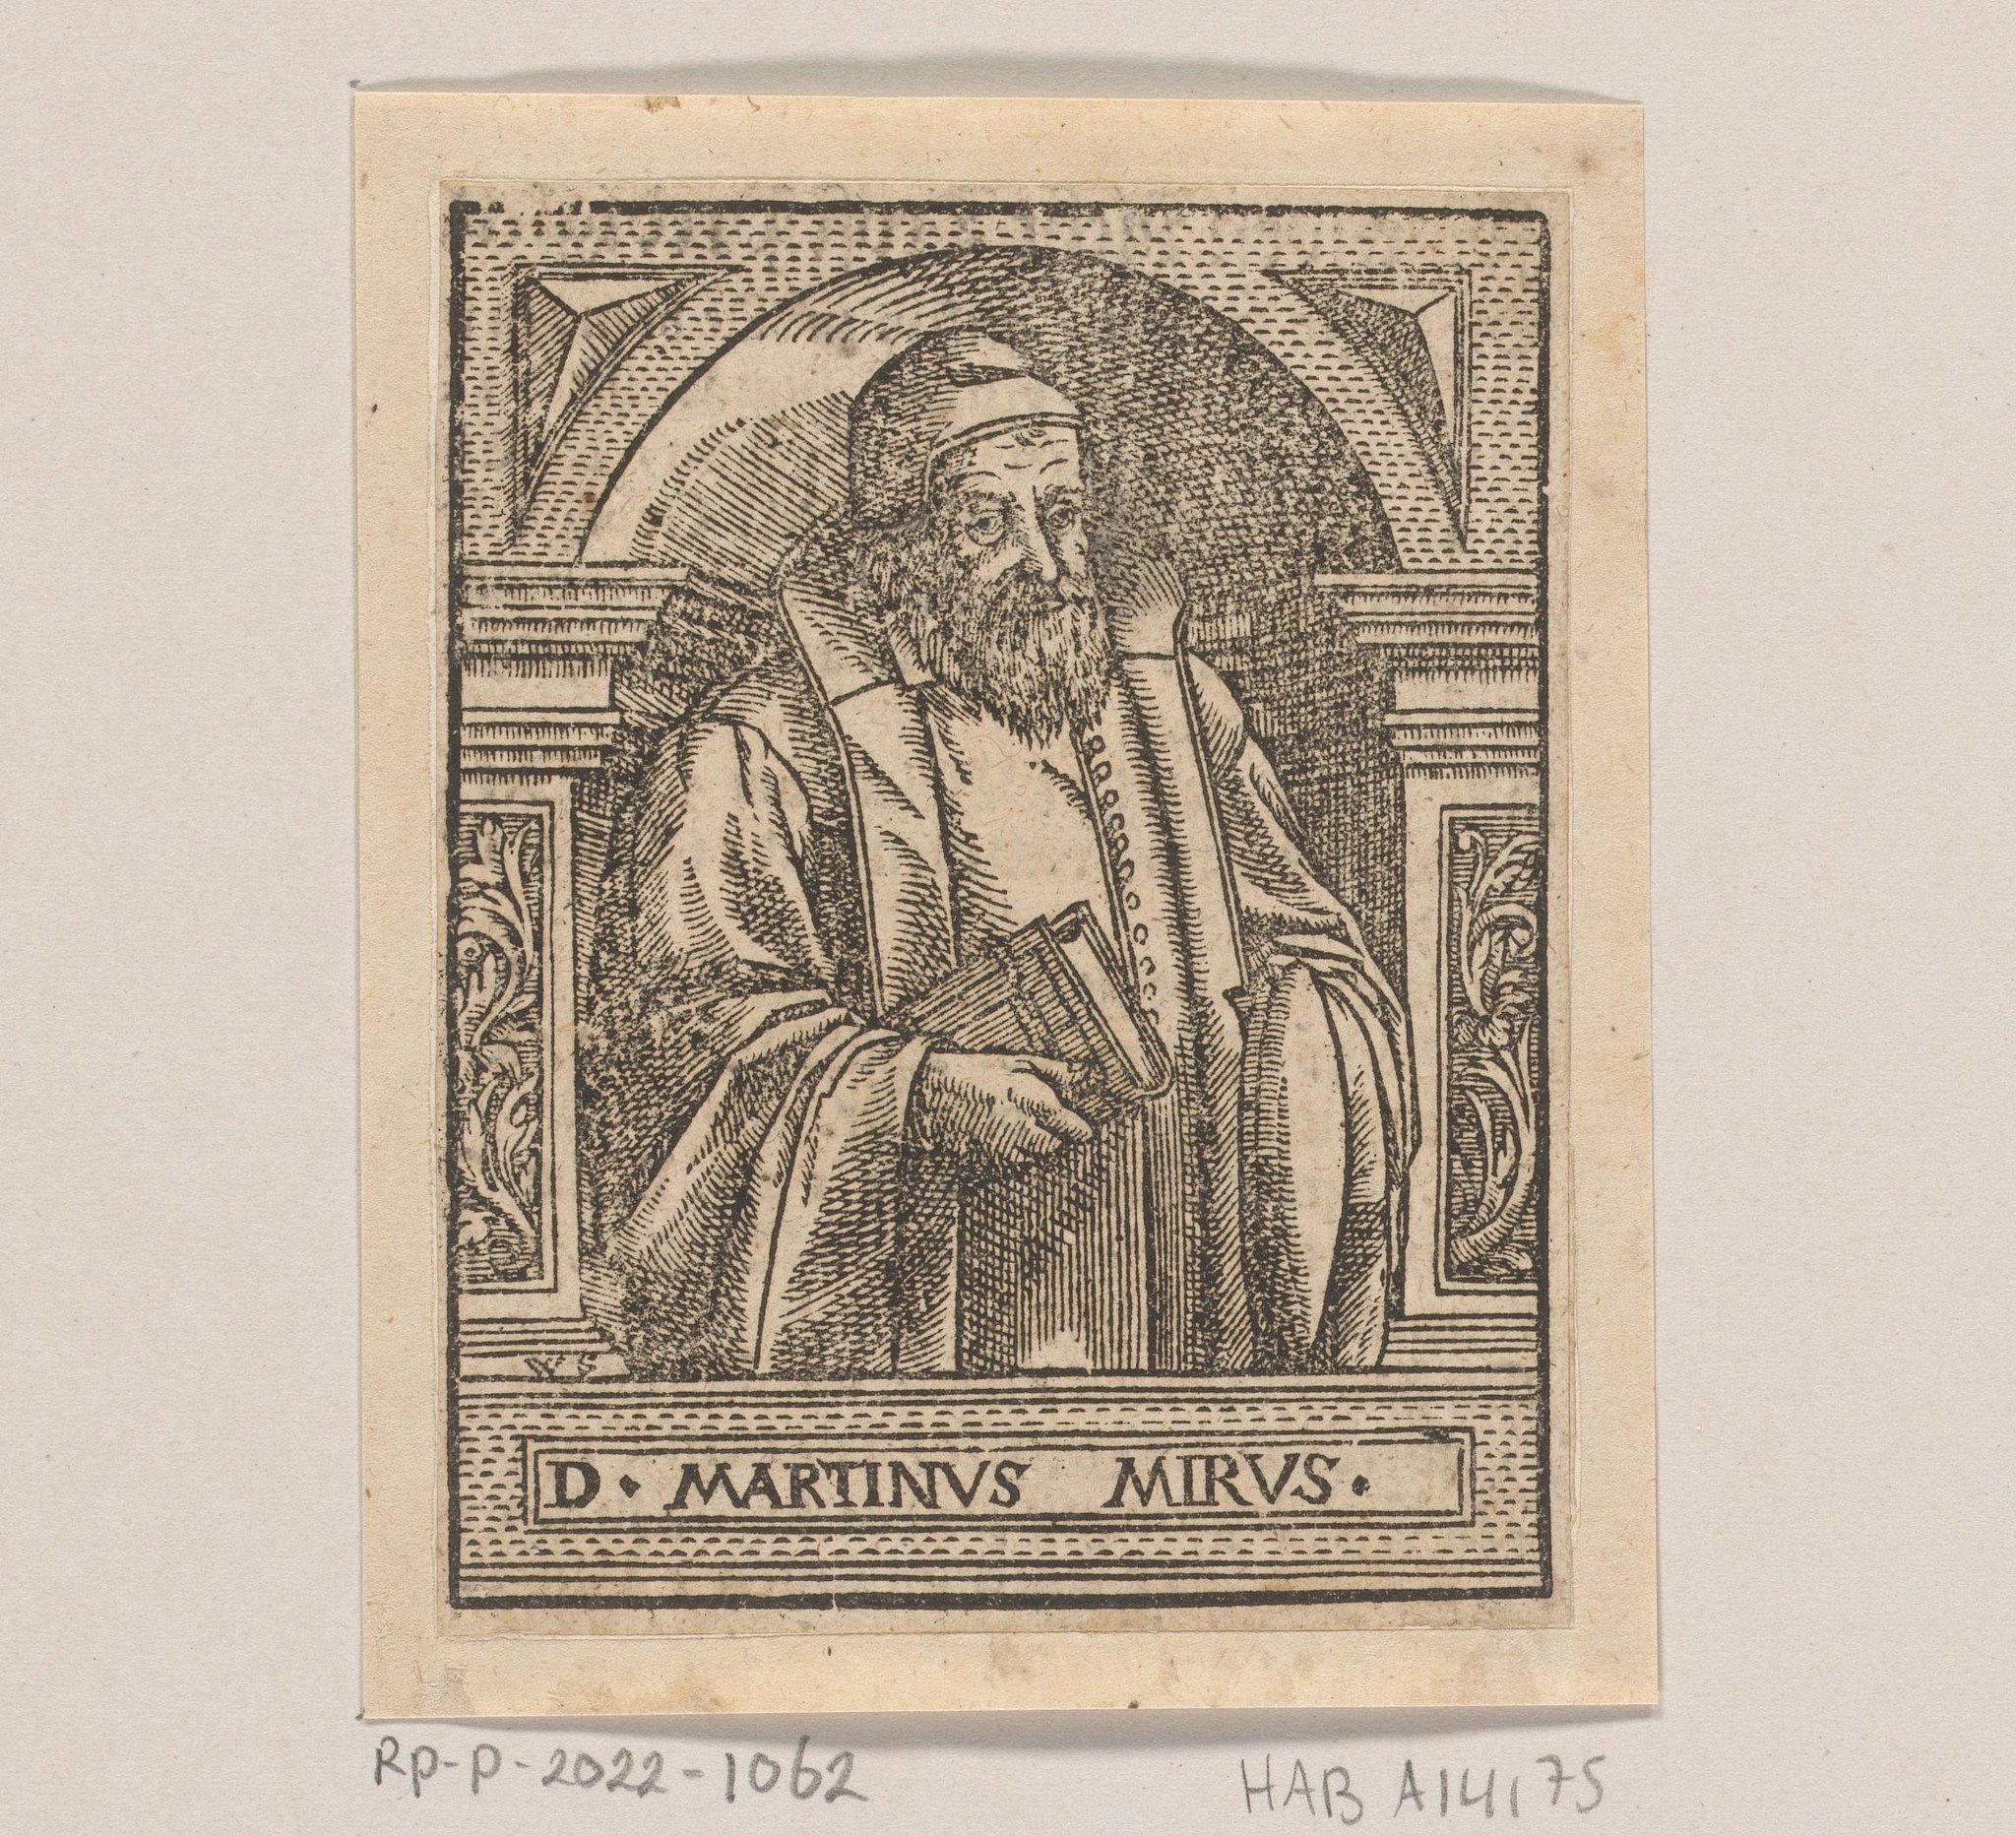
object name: book illustration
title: Portret van Martin Mirus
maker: Anonymous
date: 1597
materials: paper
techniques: letterpress printing, snipping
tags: theologian, historical persons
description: Prent waarschijnlijk uit: Mirus, Martin. Eine herrliche Predigt: uber den schönen Spruch: Also hat Gott die Welt geliebet (...). Dresden: Gimel Bergen, 1597.